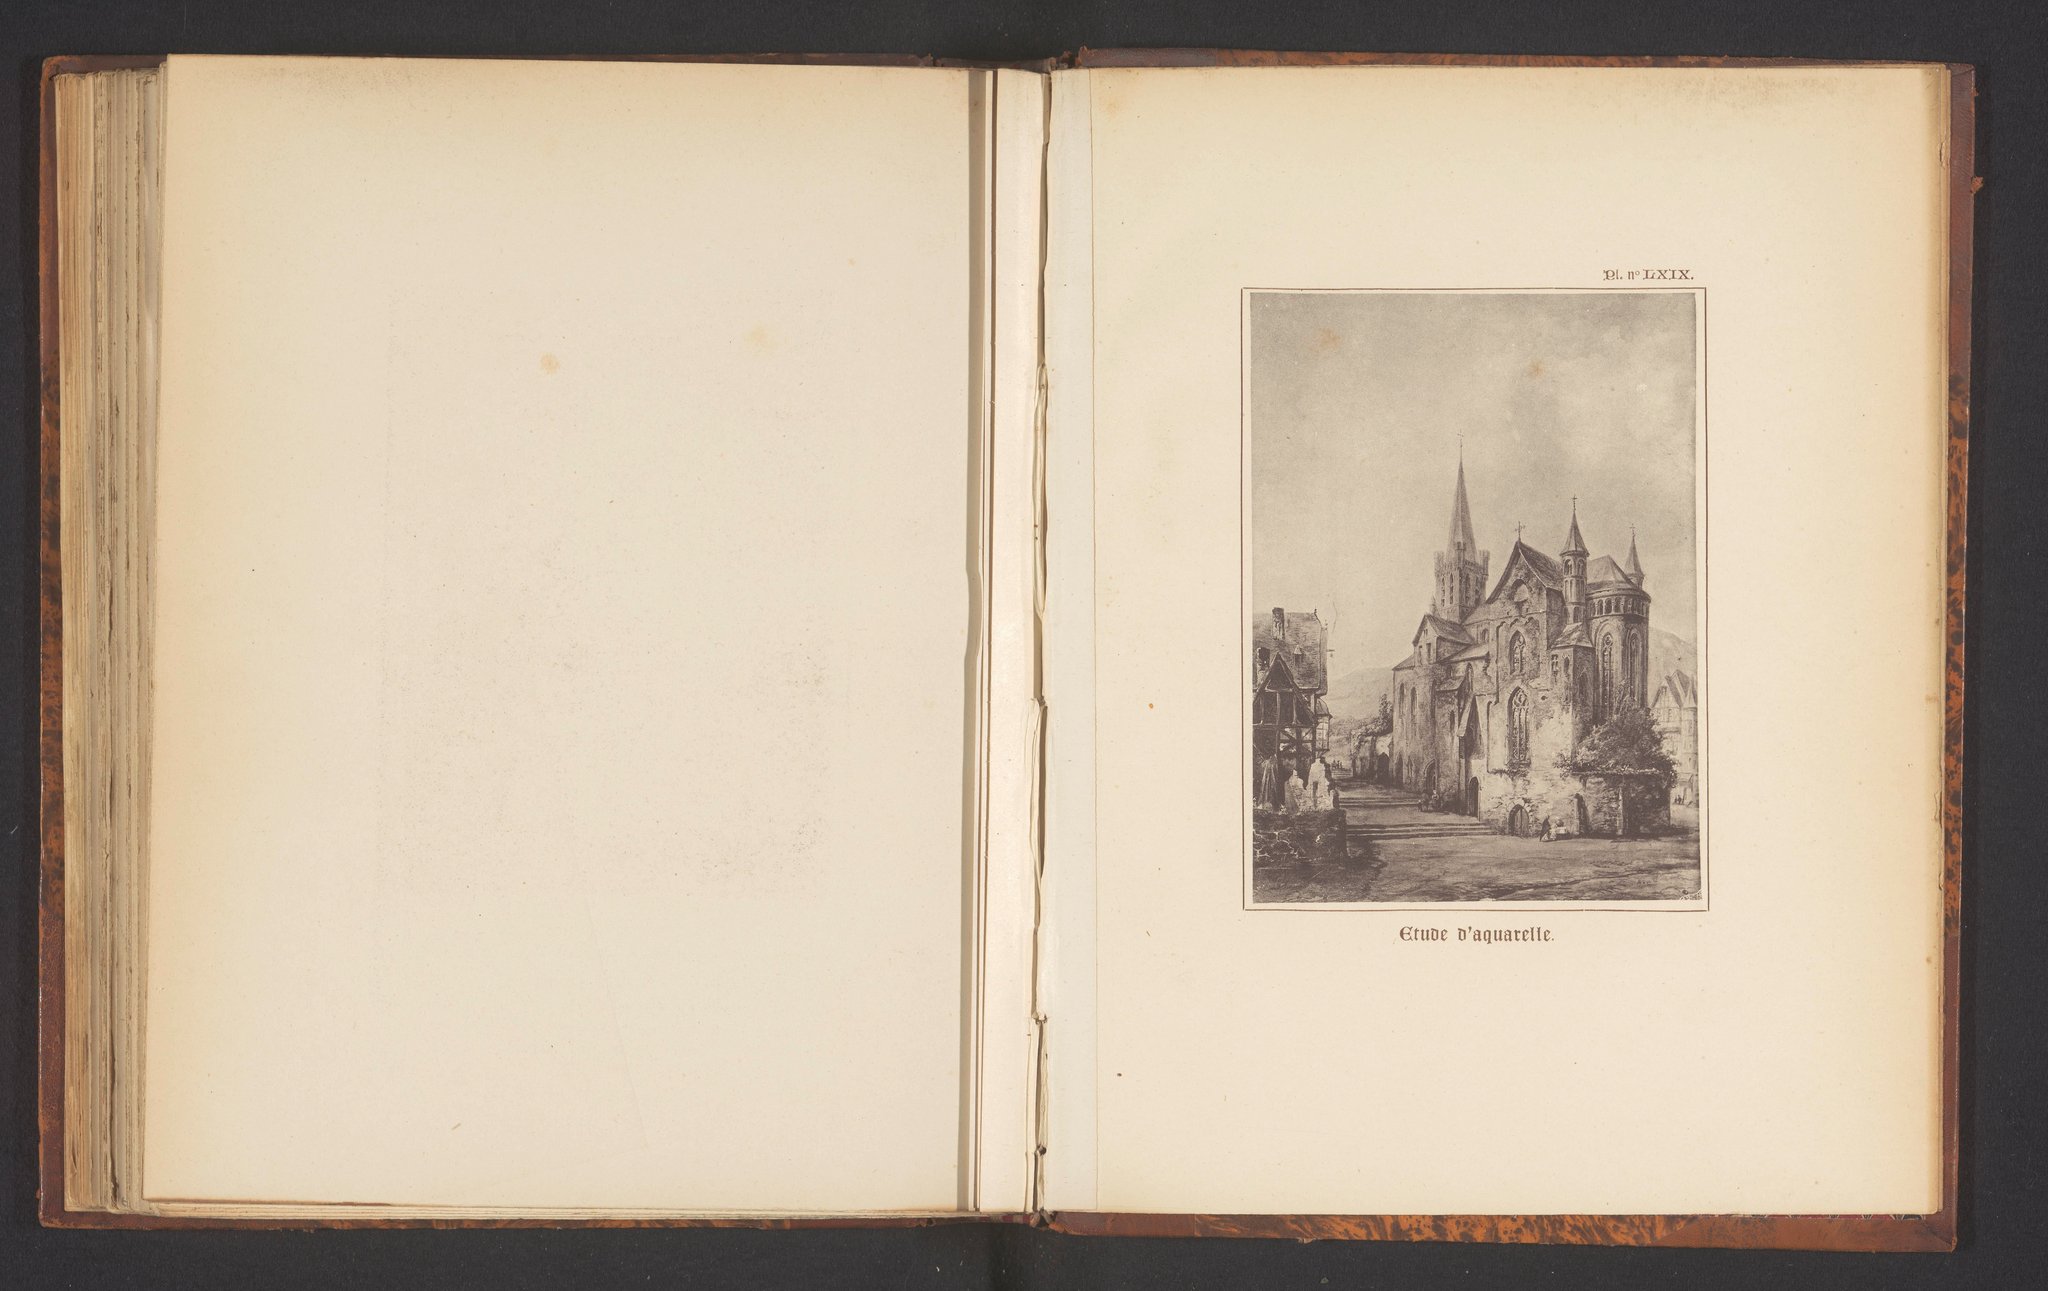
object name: page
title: Etude d'aquarelle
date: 1891-1896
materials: paper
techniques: photograph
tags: church (exterior), street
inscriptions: number: ‘Pl. no LXIX.’